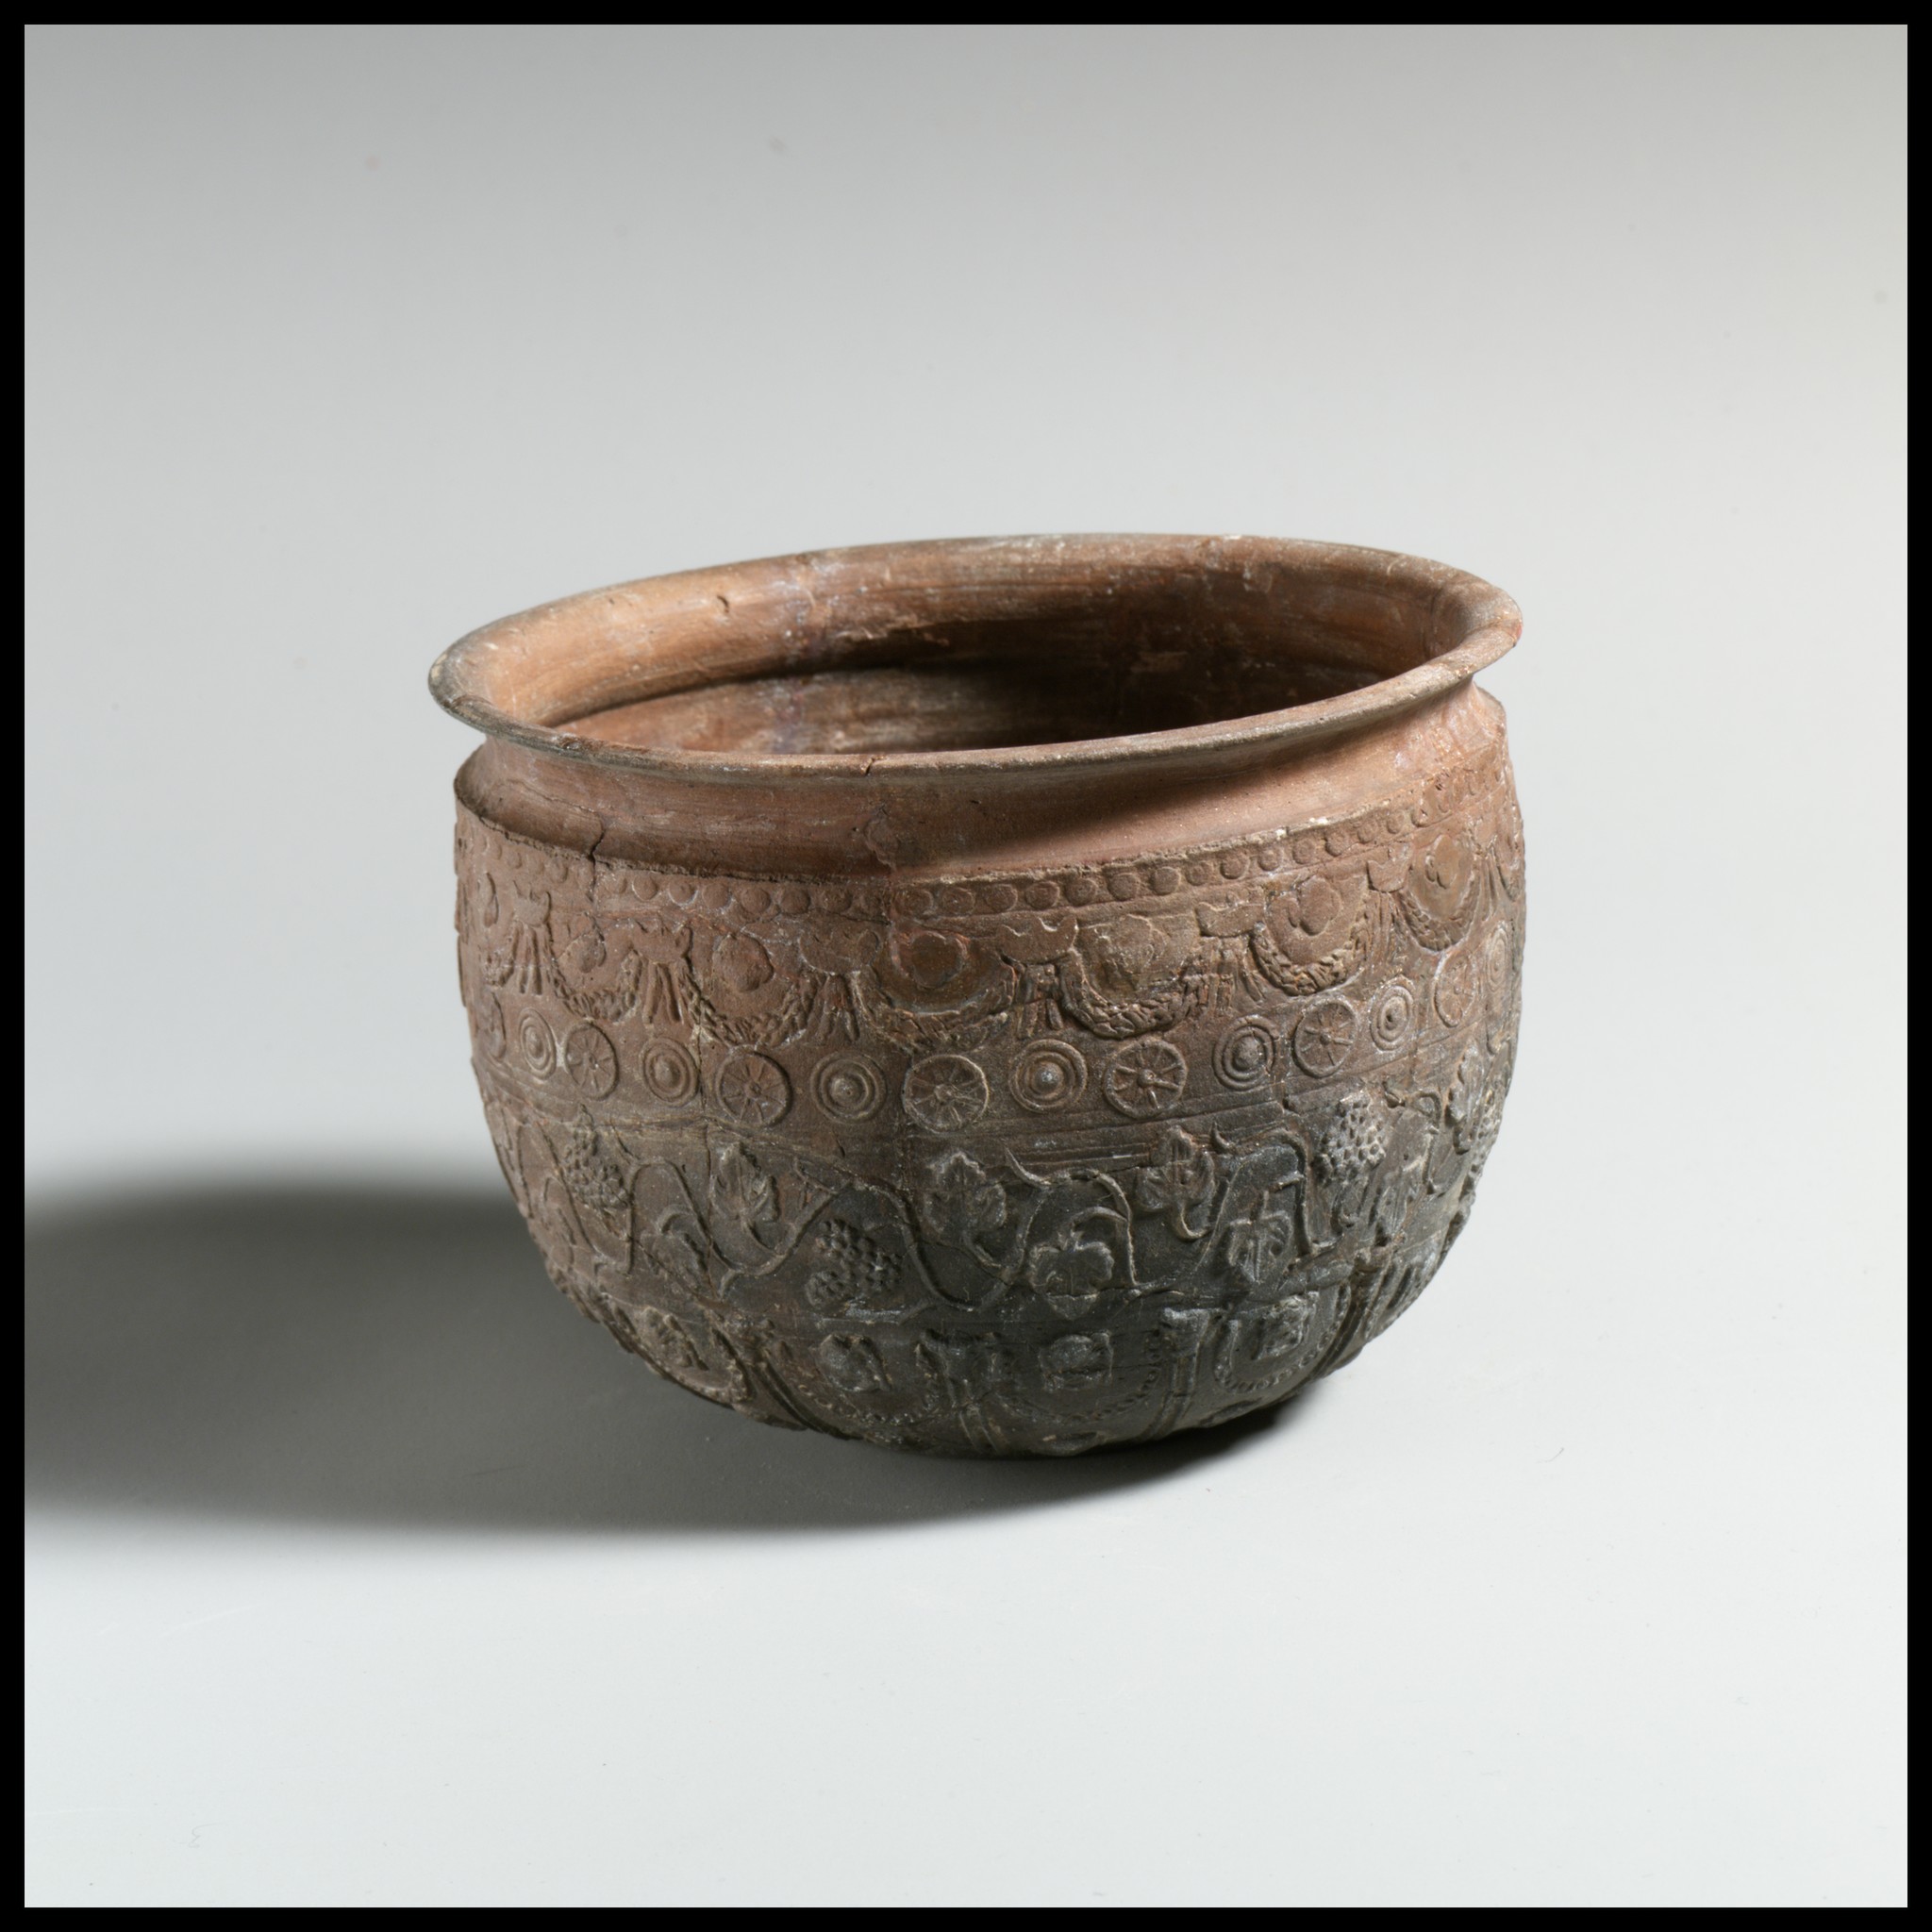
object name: bowl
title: Terracotta Megarian bowl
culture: roman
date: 150-75 BCE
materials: terracotta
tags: shields,satyrs